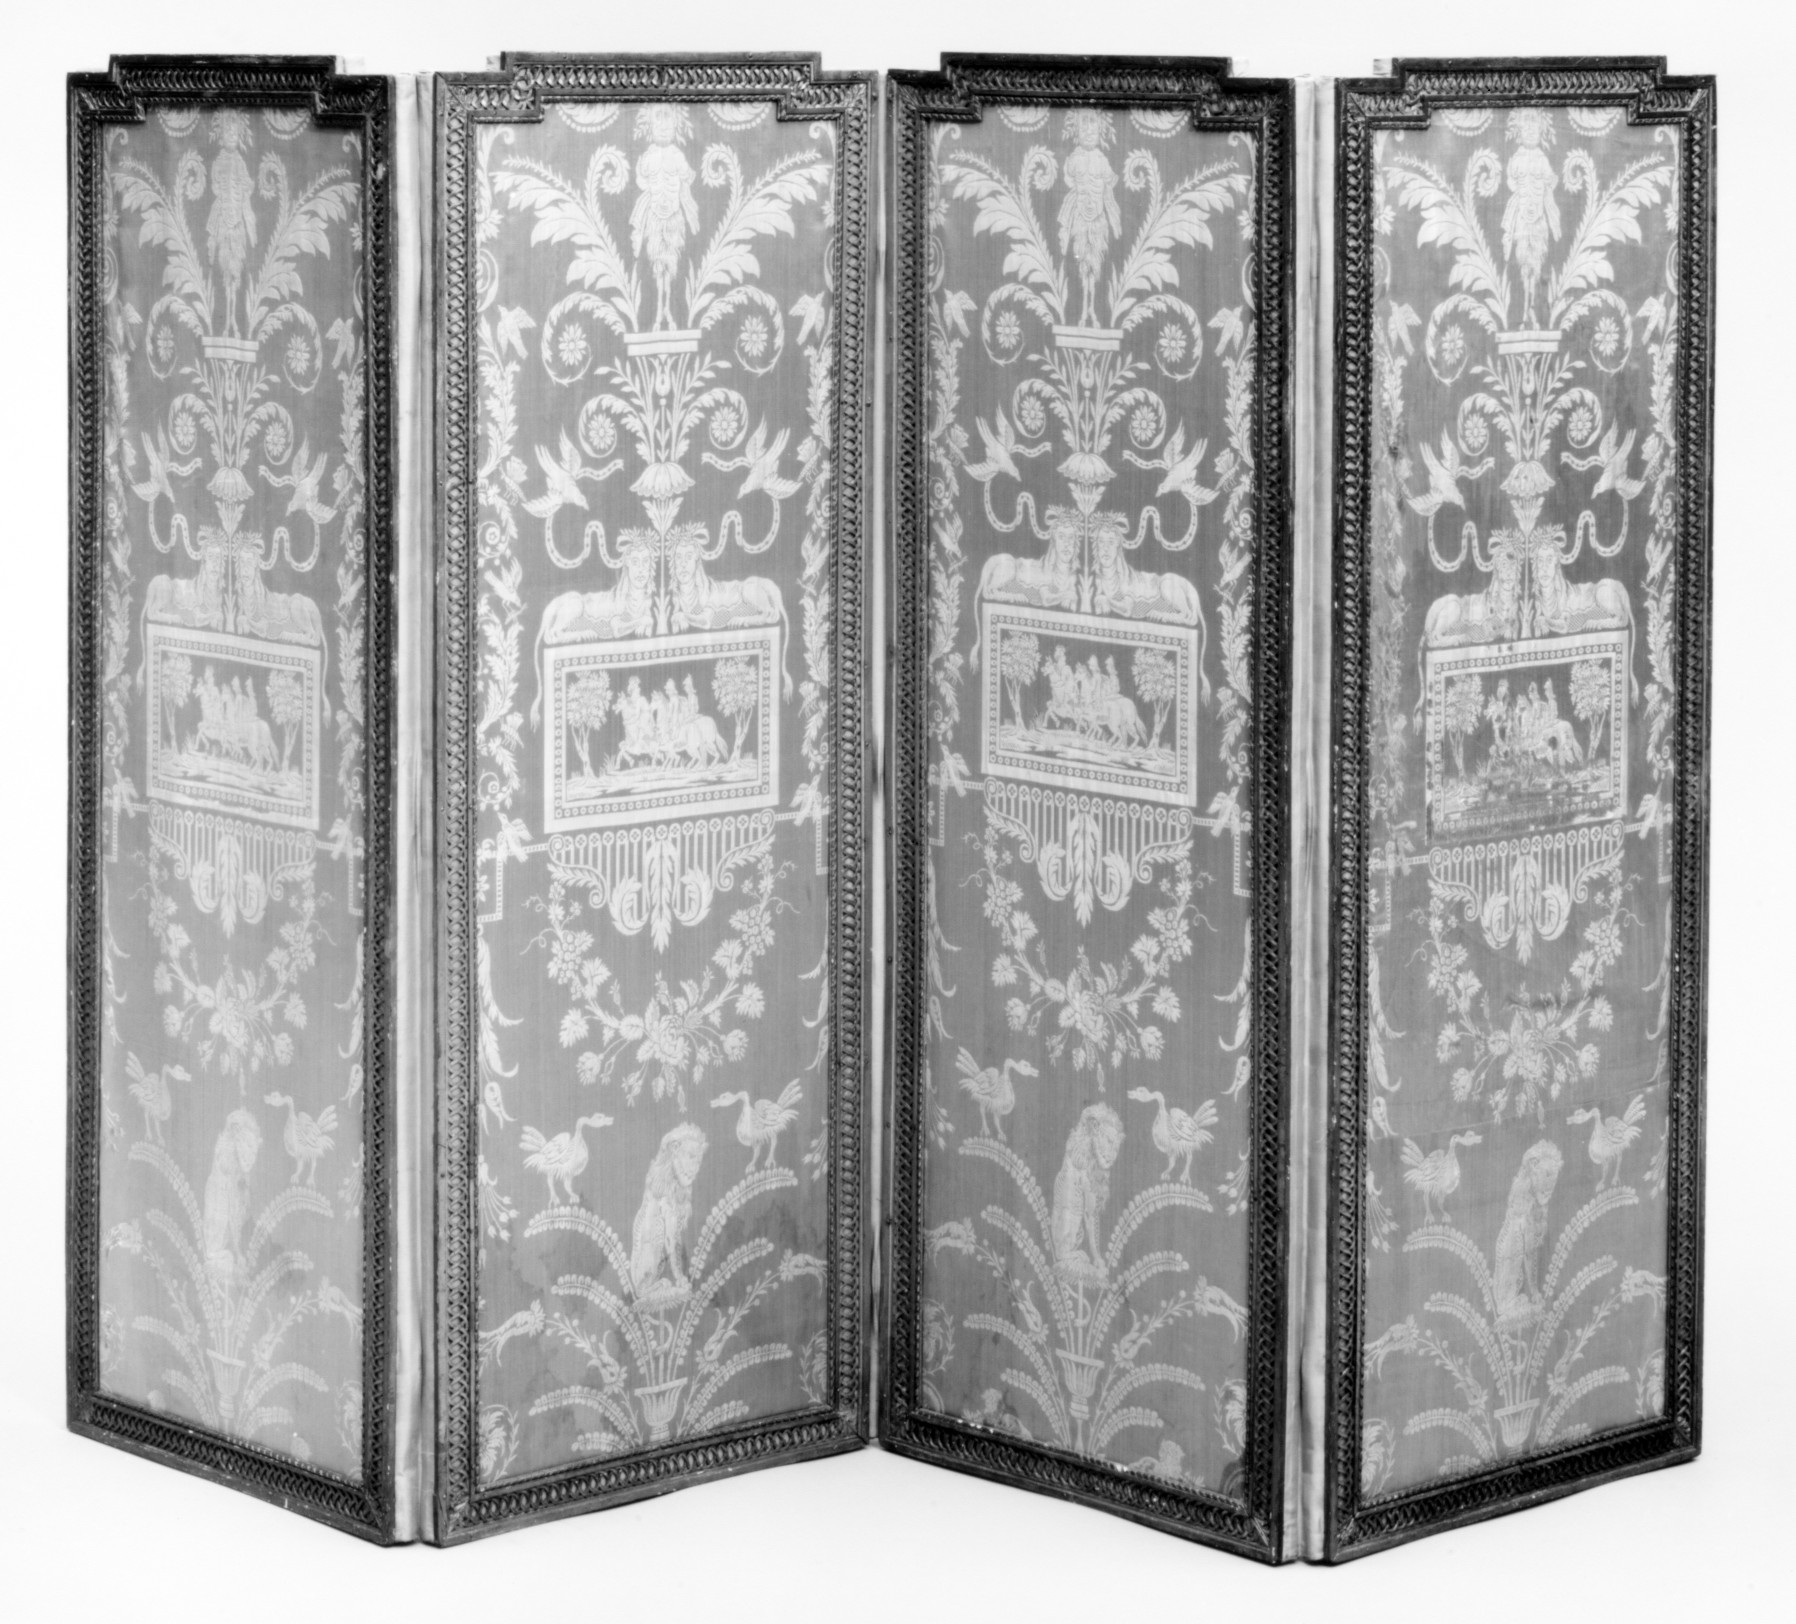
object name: folding screen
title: Four-leaf folding screen (Paravent)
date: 1780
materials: wood, silk, silver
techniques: carving, gilding, lampas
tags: birds,horses,flowers